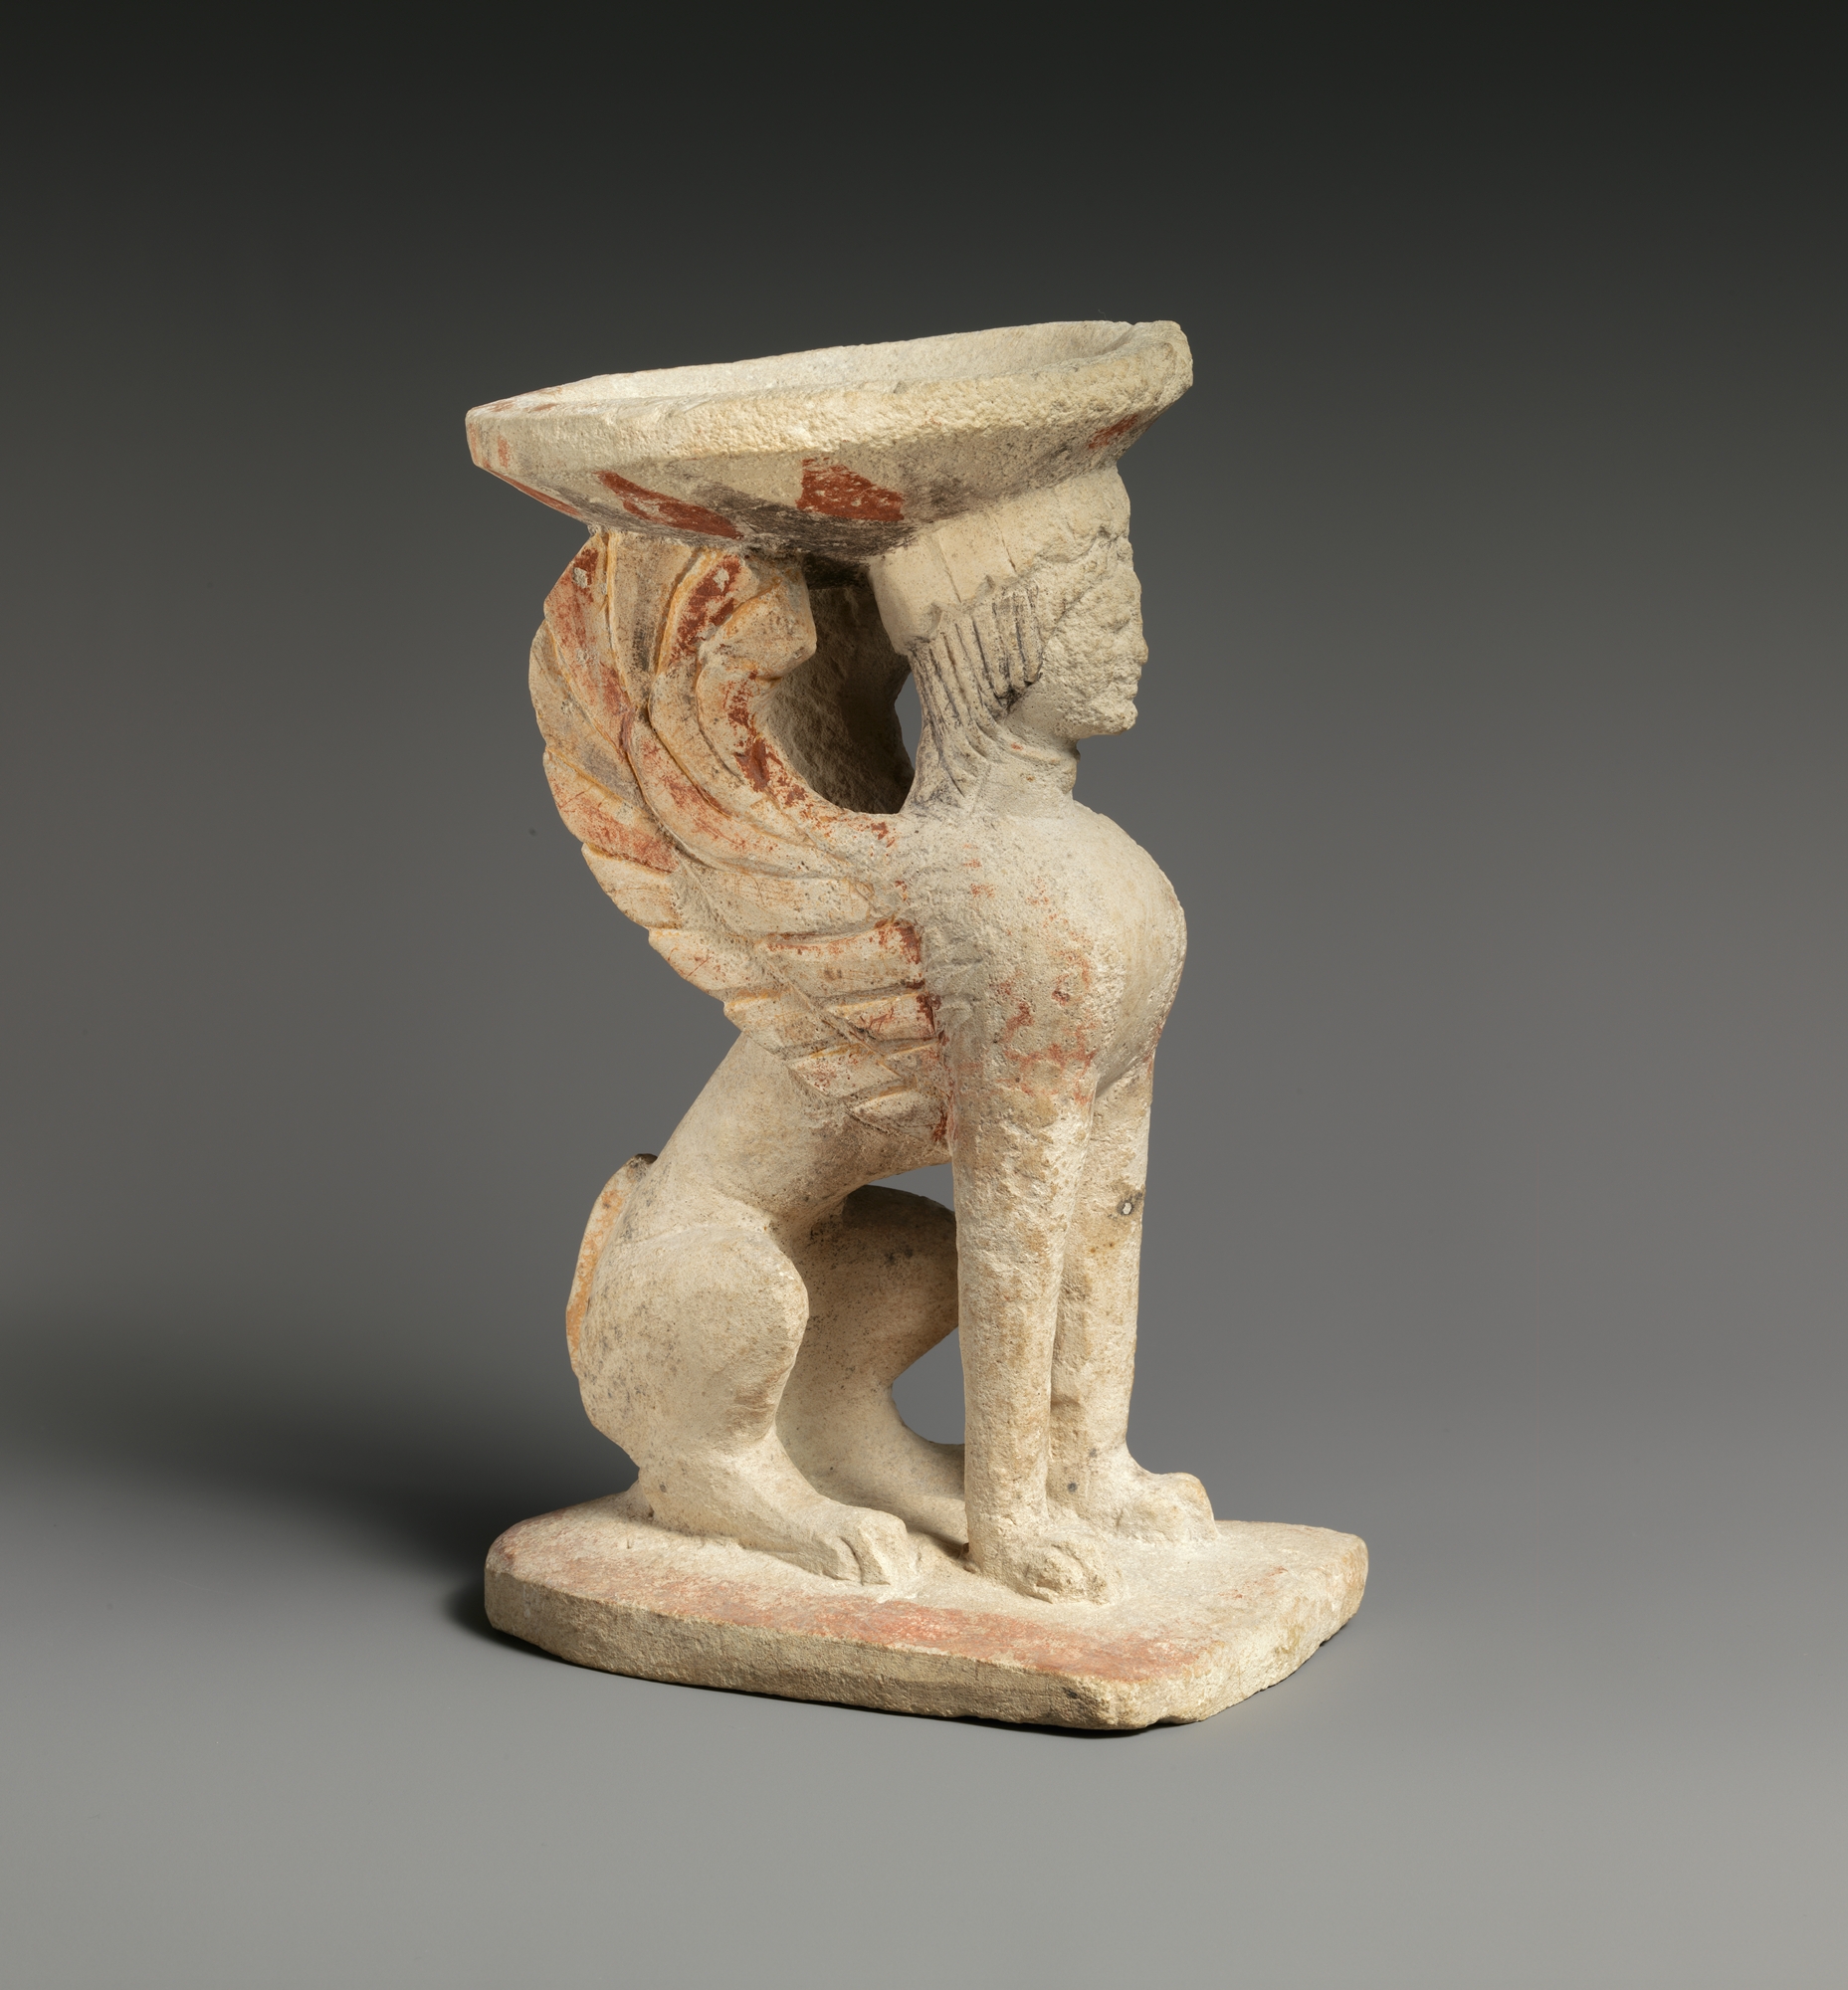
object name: statue of a sphinx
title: Limestone thymiaterion (incense burner)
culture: cypriot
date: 475-451 BCE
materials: limestone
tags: sphinx